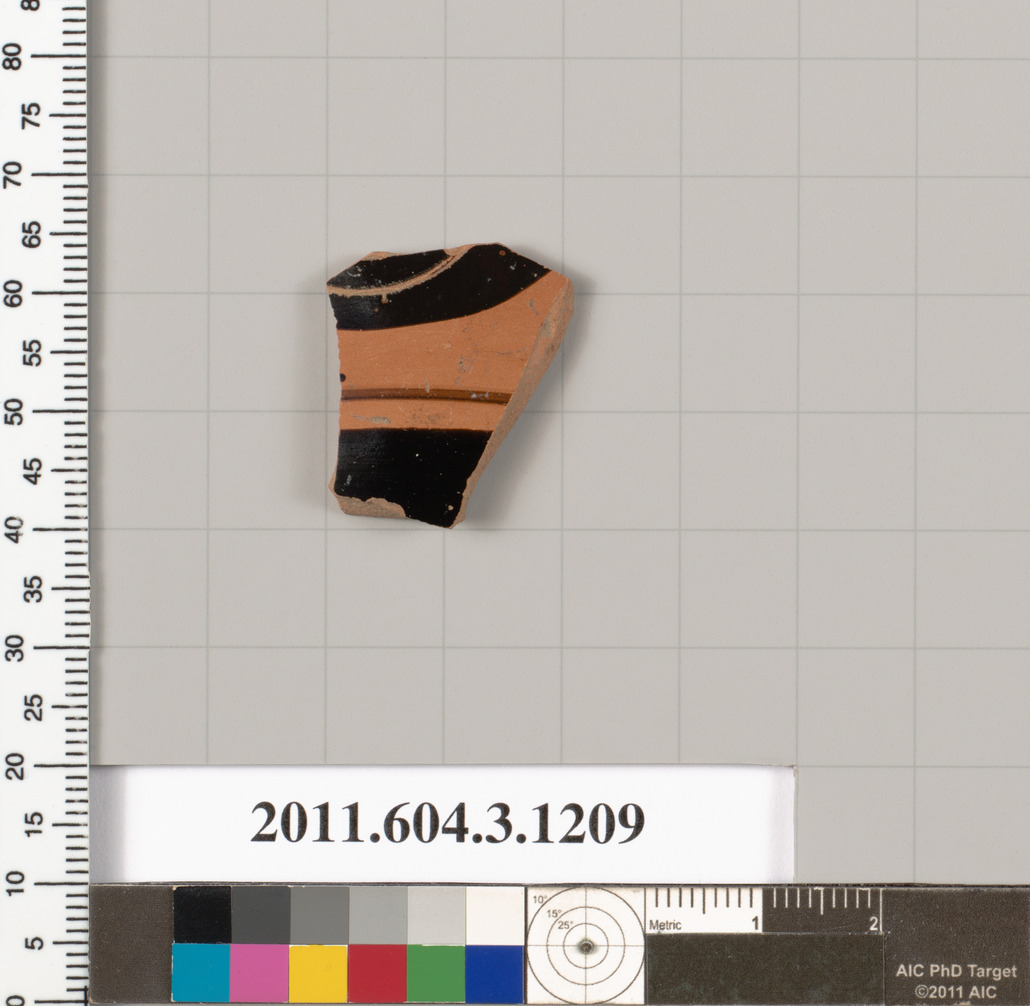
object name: mastoid or kyathos fragment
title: Terracotta fragment of a mastoid (drinking cup with narrow base) or a kyathos (cup-shaped ladle)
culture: greek, attic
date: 534-468 BCE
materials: terracotta